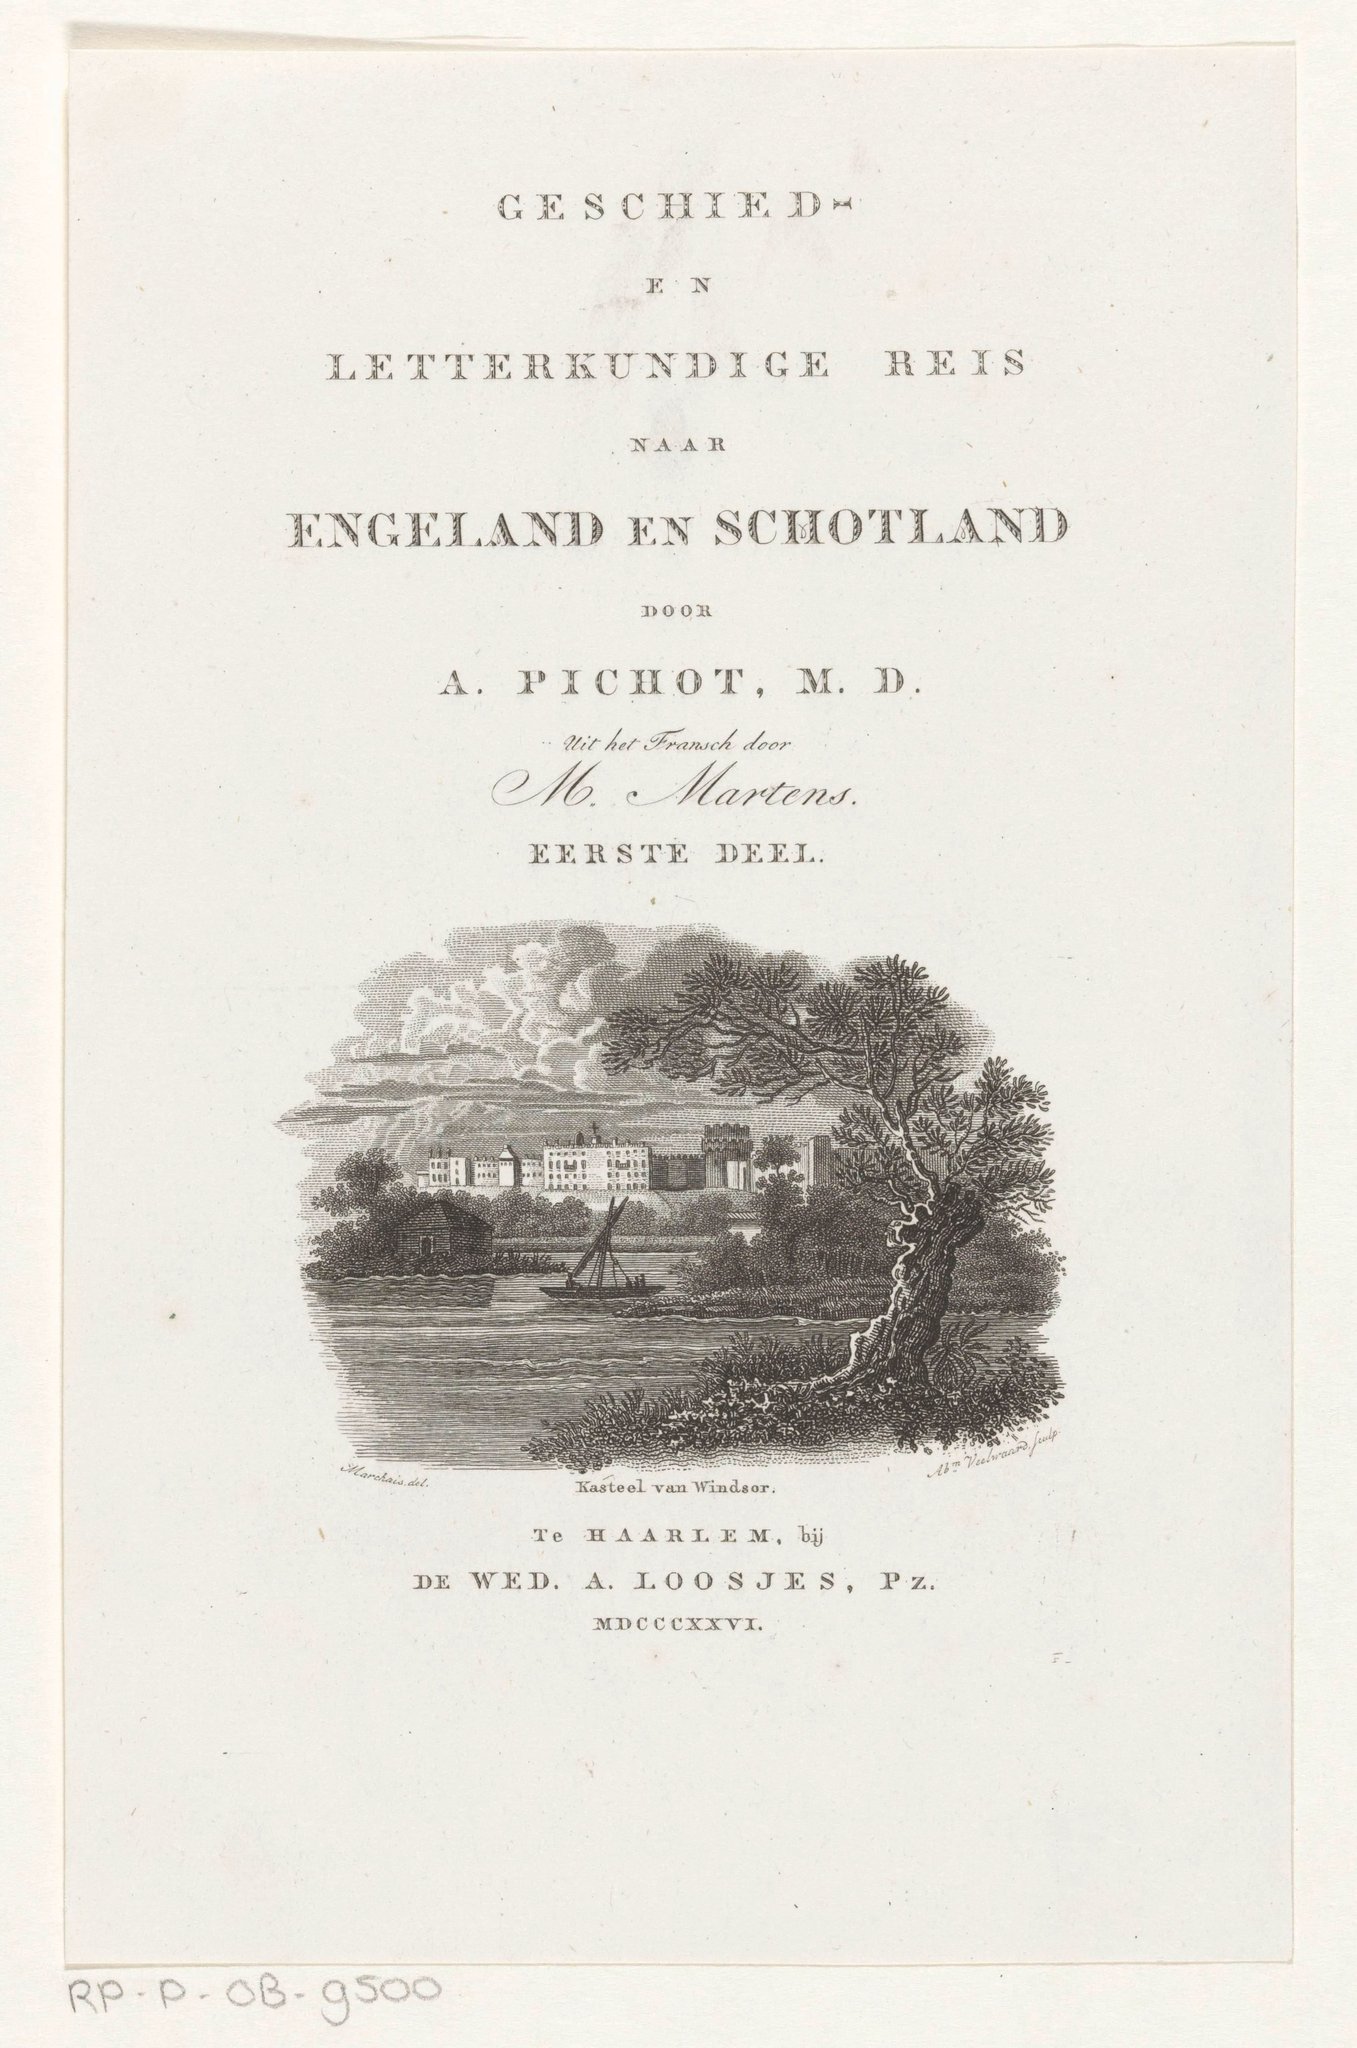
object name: print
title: Titelpagina voor: A. Pichot, Geschied- en letterkundige reis naar Engeland en Schotland, 1826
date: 1826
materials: paper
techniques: engraving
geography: haarlem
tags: castle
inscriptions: collector's mark: Lugt 2228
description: Titelpagina voor: Pichot, A. Geschied- en letterkundige reis naar Engeland en Schotland. Haarlem: Loosjes Pz., weduwe Adriaan, 1826.